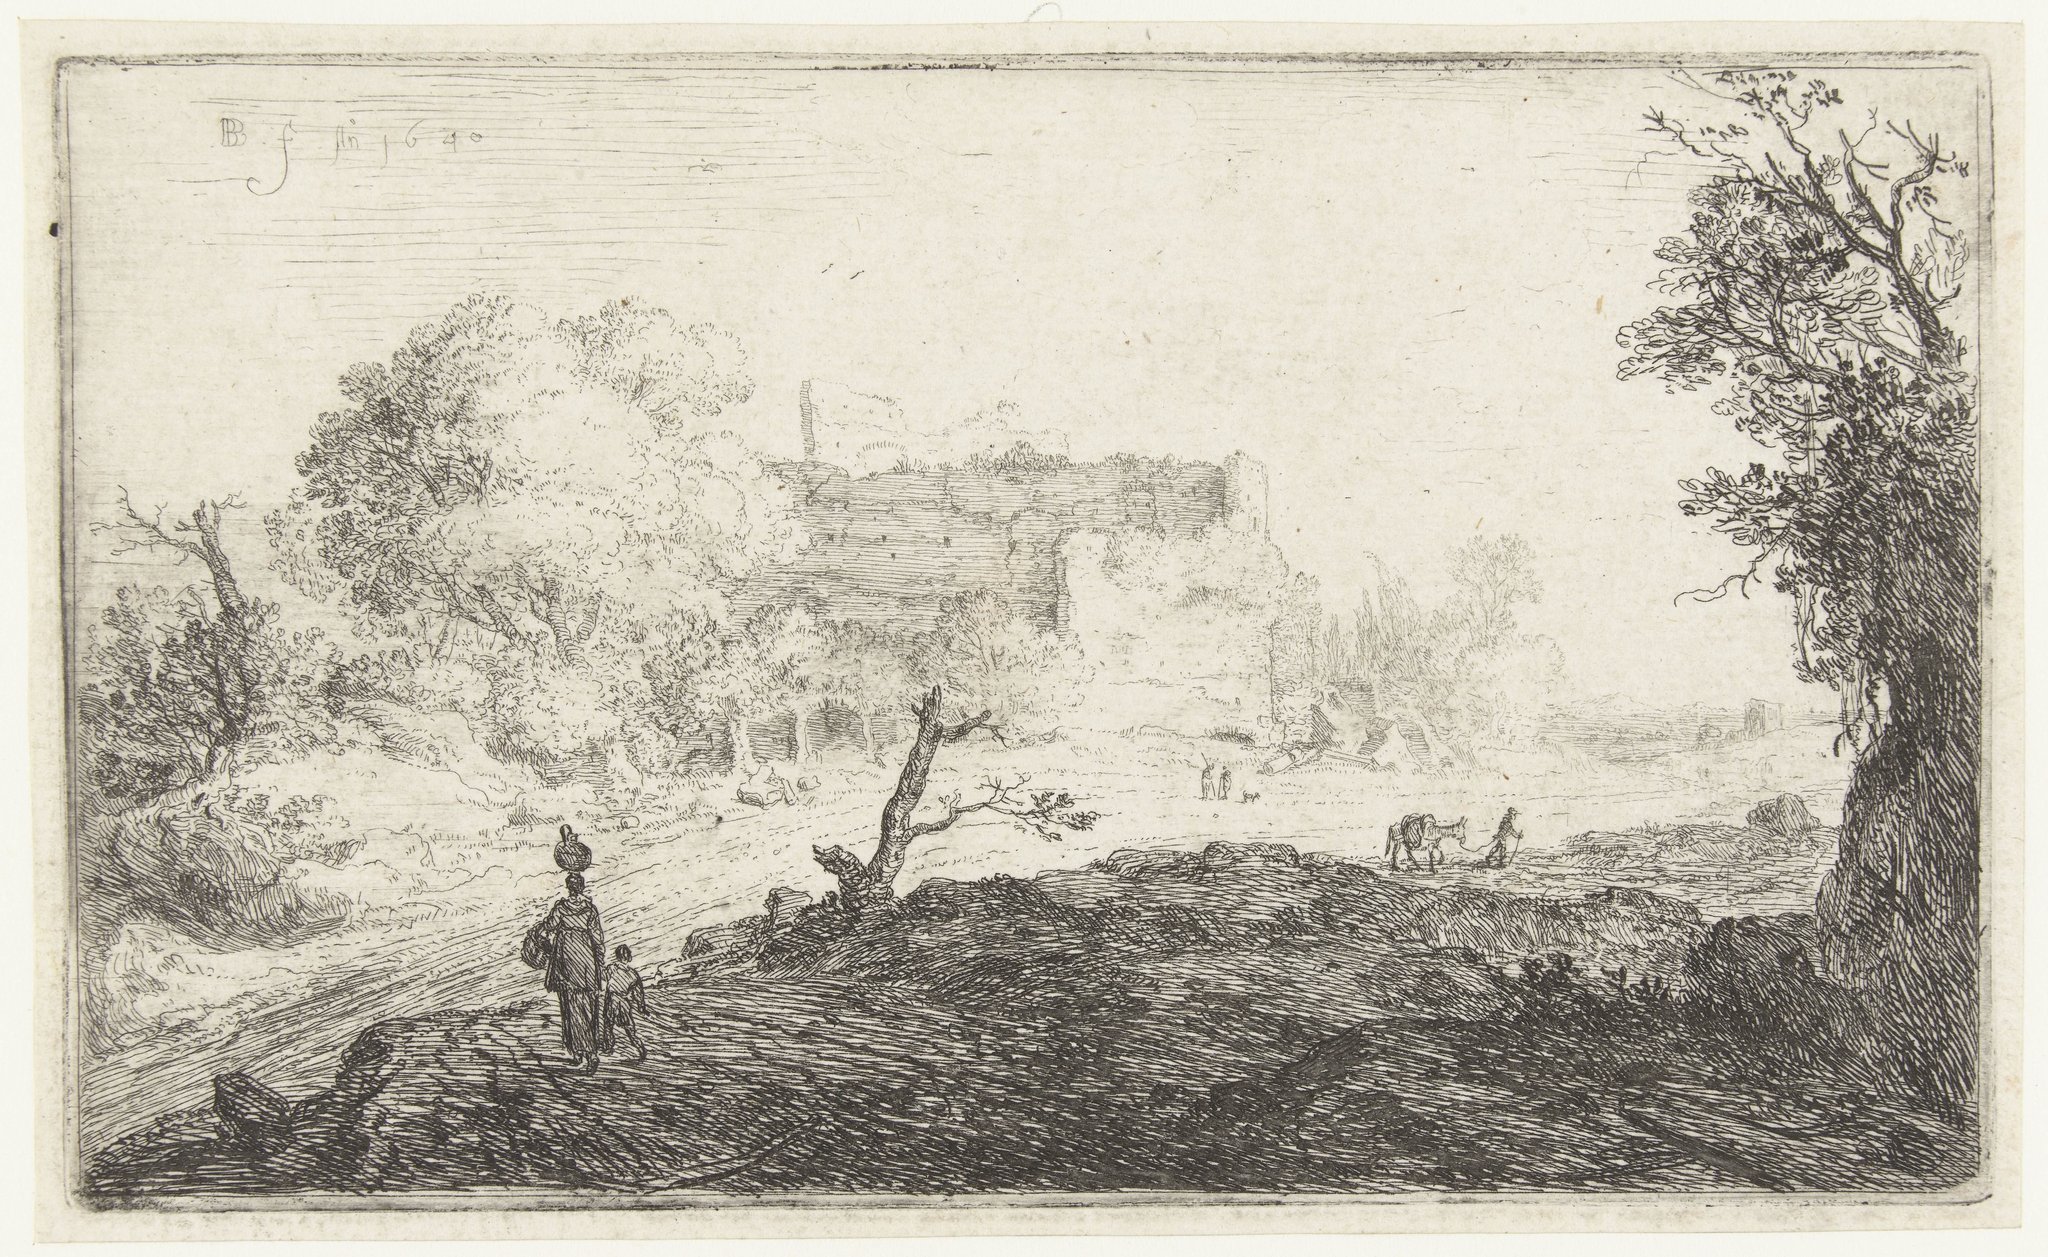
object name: print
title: Vrouw met kind bij de ruïnes van het Colosseum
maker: bartholomeus breenbergh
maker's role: draughtsman, print maker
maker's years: 1599-1657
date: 1640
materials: paper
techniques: etching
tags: low hill country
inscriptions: collector's mark: Lugt 240